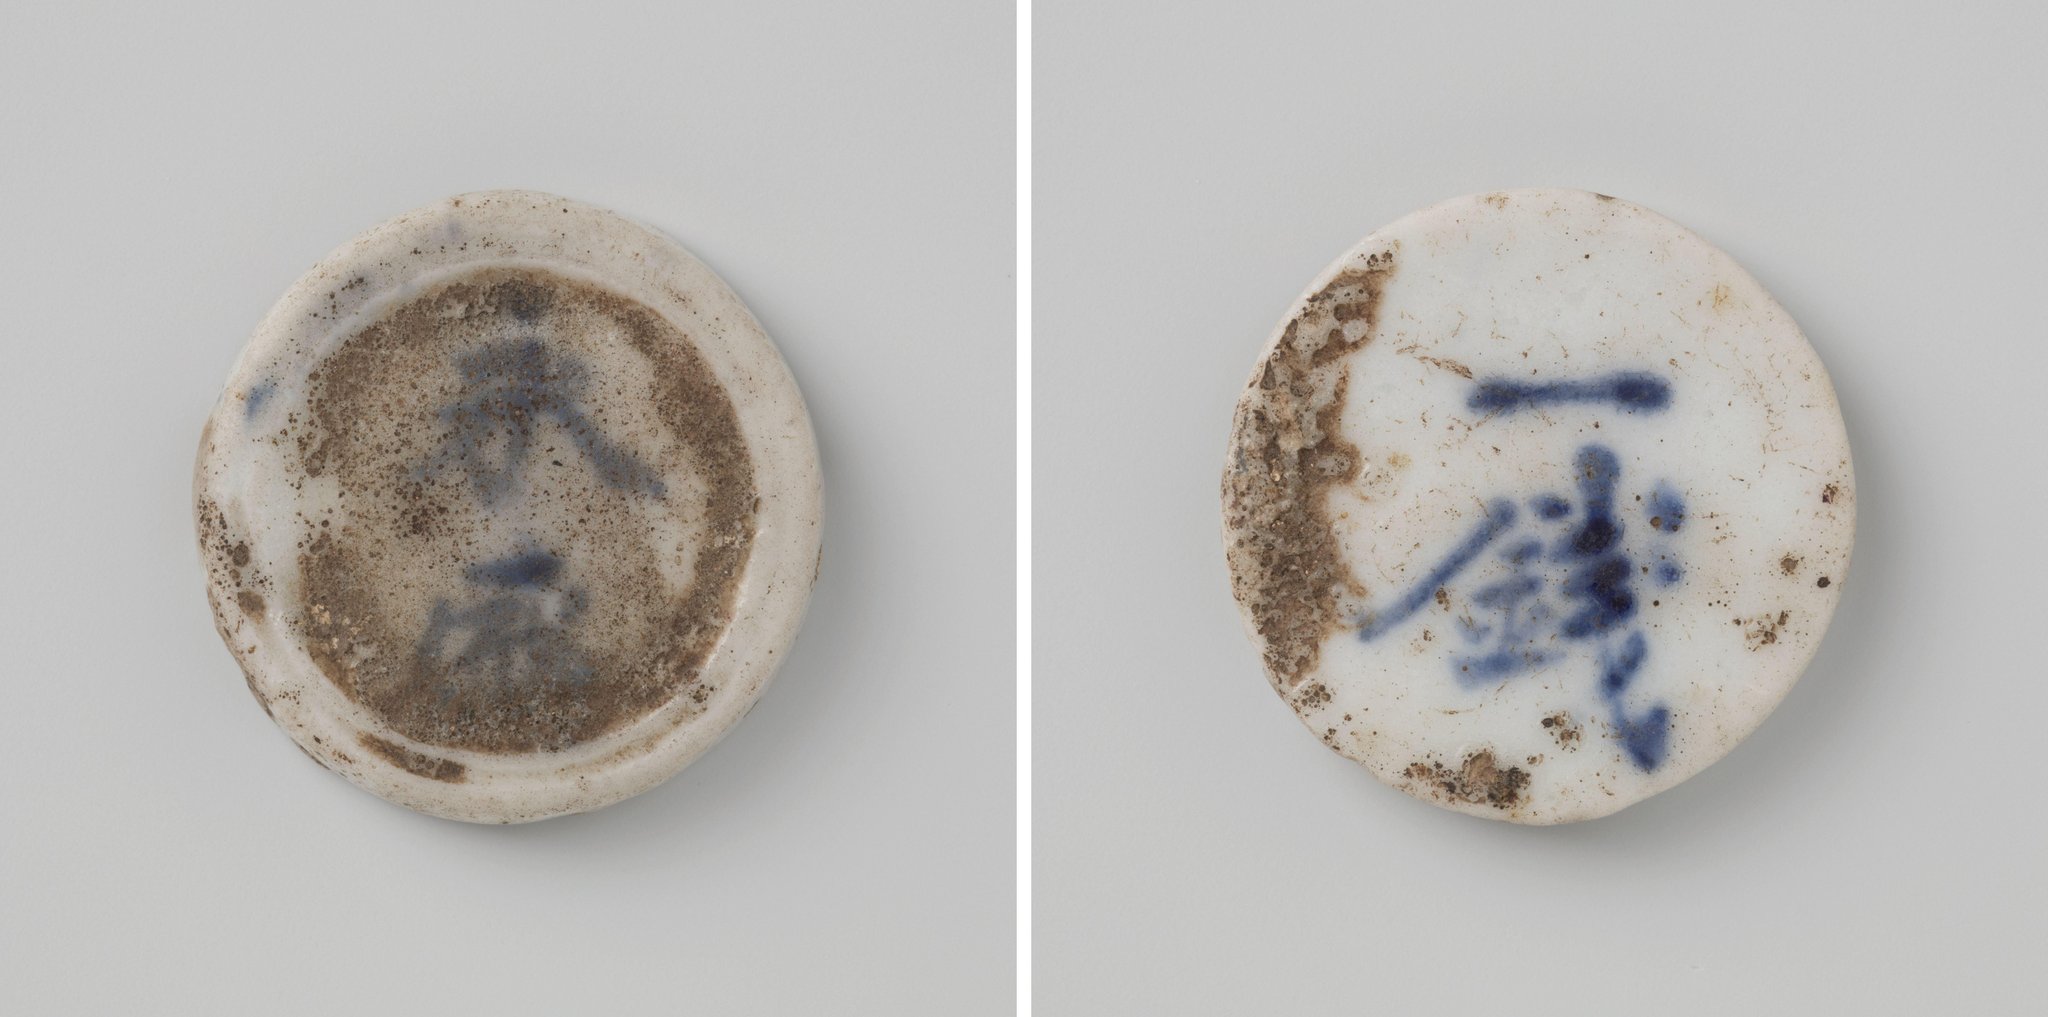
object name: coin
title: Speelhuispenning uit Thailand ter waarde van een salung, 1760-1871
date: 1760-1871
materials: porcelain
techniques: firing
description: Ronde porseleinen speelhuispenning, die ook als munt is gebruikt. Voorzijde: twee Chinese karakters. Keerzijde: een Chineese karakter.